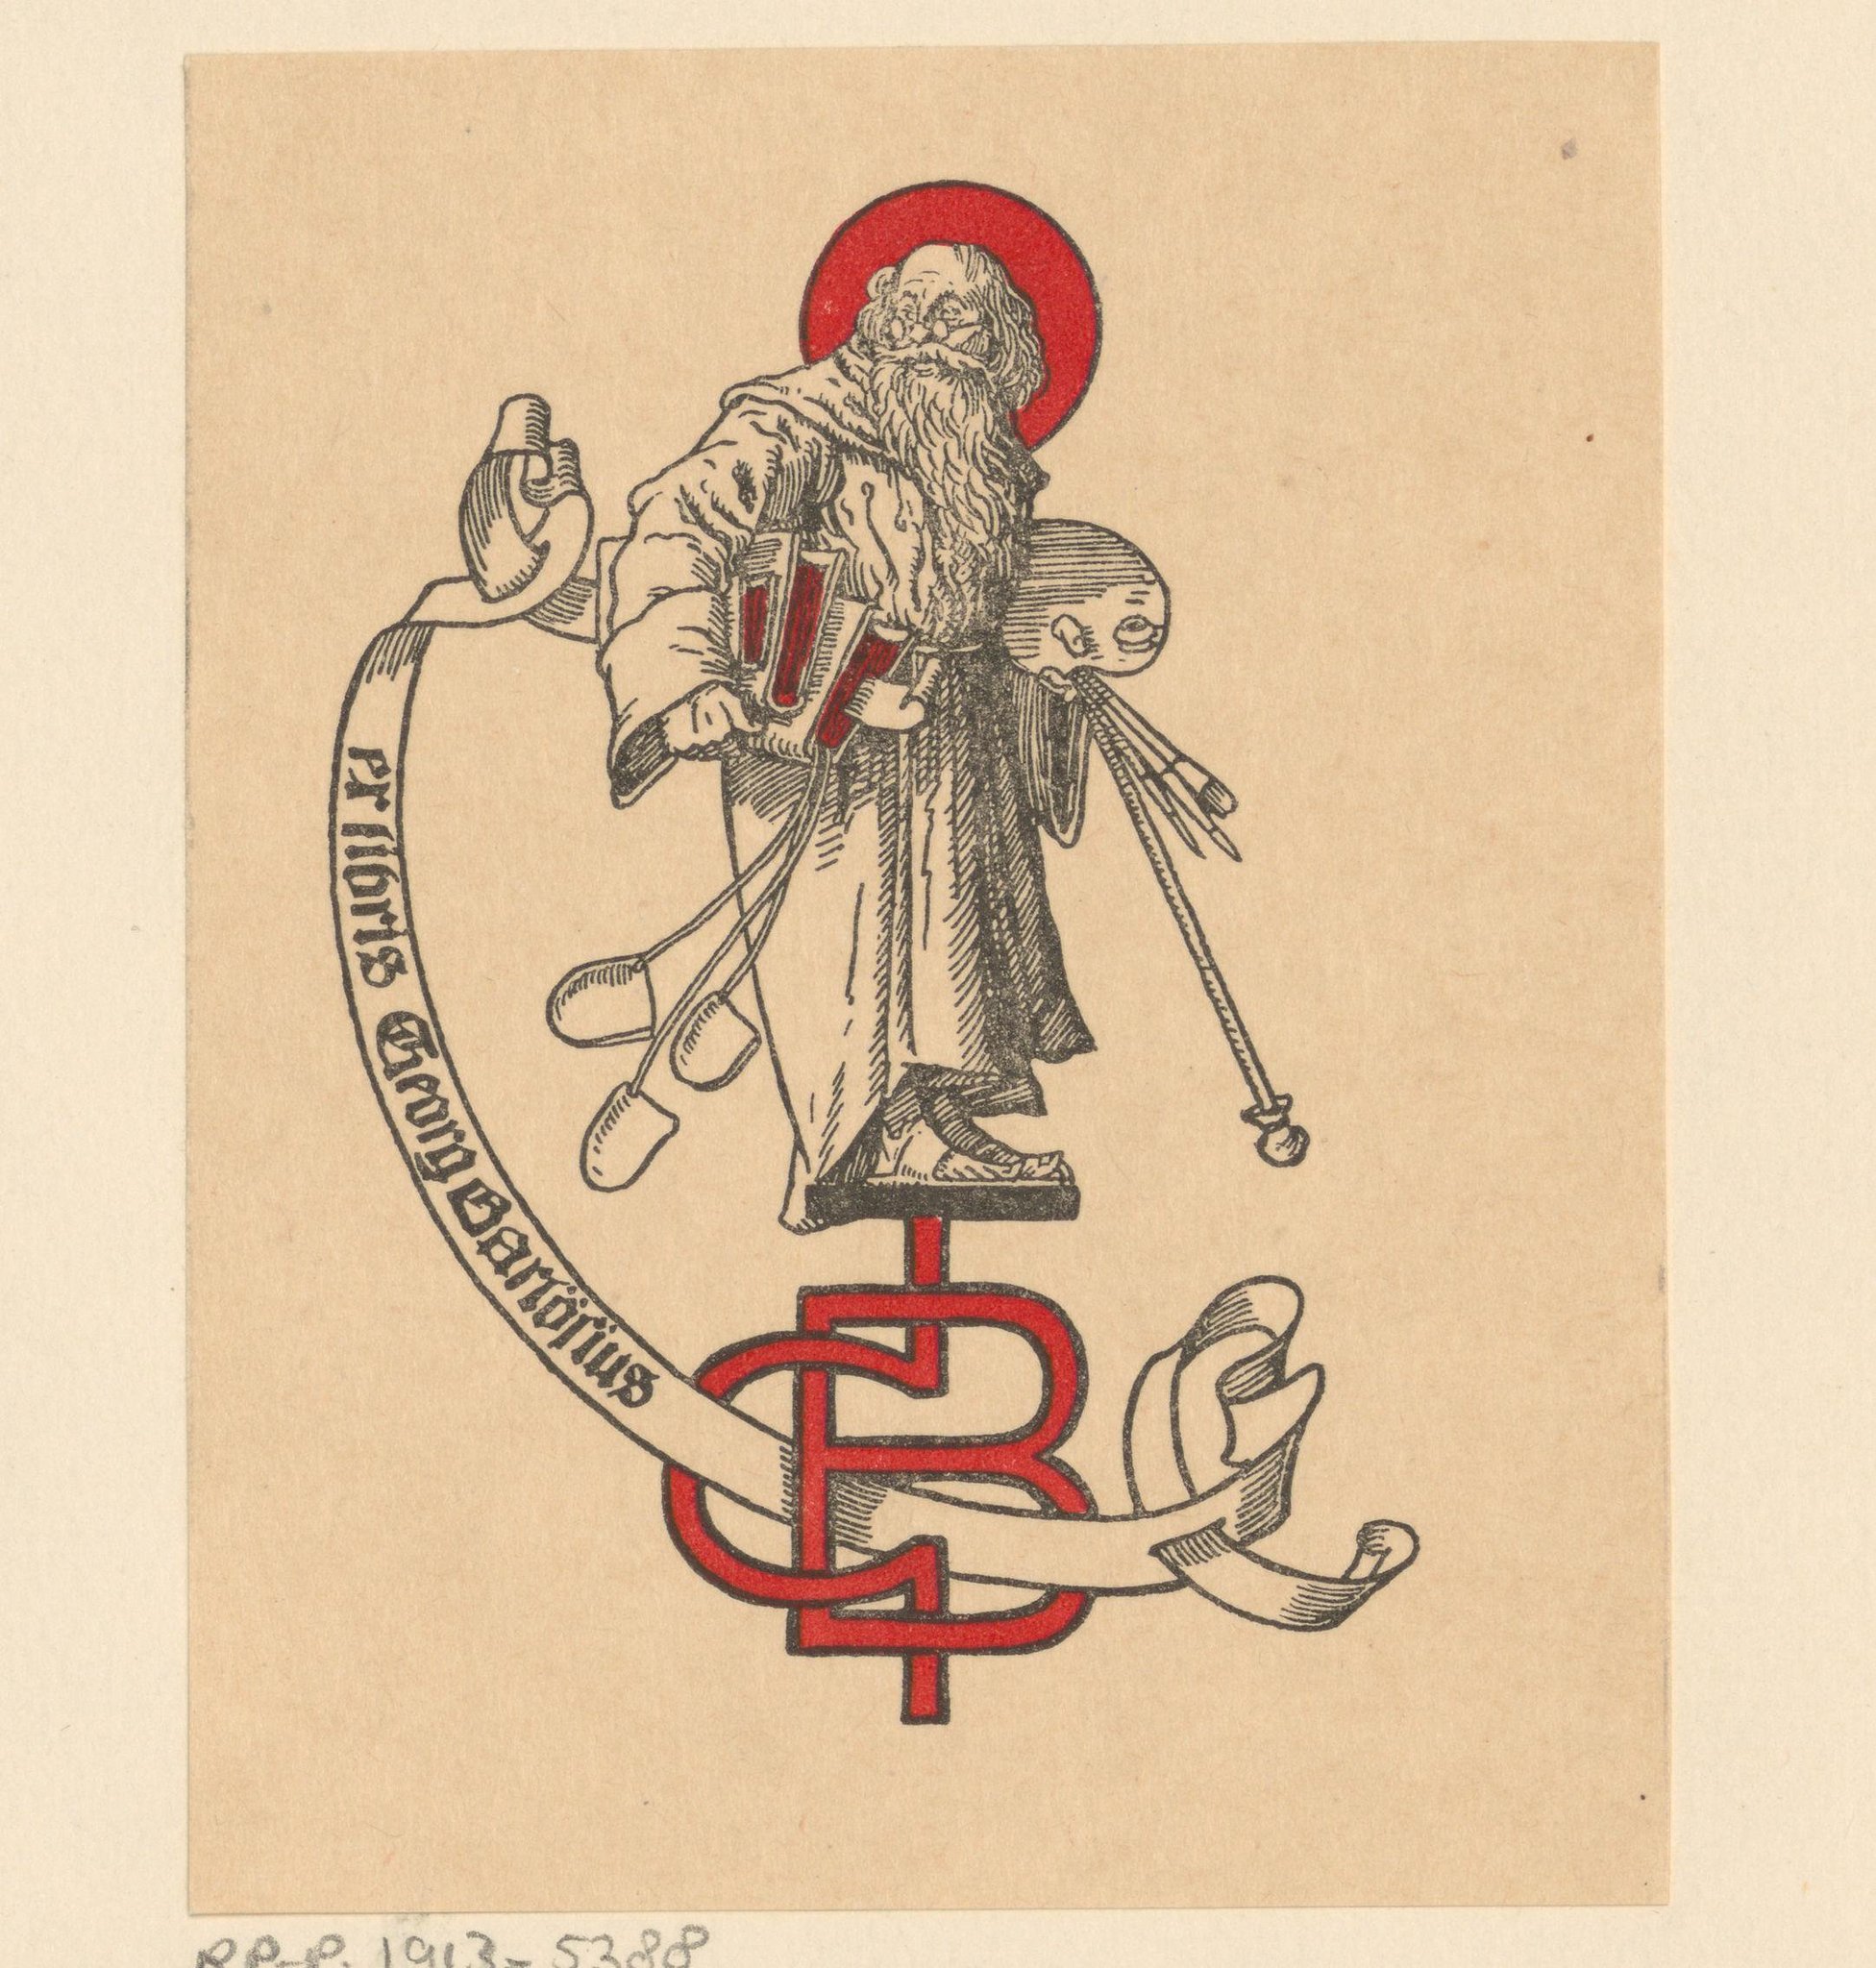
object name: bookplate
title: Ex libris van Georg Barlösius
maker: Anonymous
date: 1901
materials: paper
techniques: printing block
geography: germany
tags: georg barlösius, saints, old man, book, palette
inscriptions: collector's mark: Lugt 2233, collector's mark: Lugt 2760